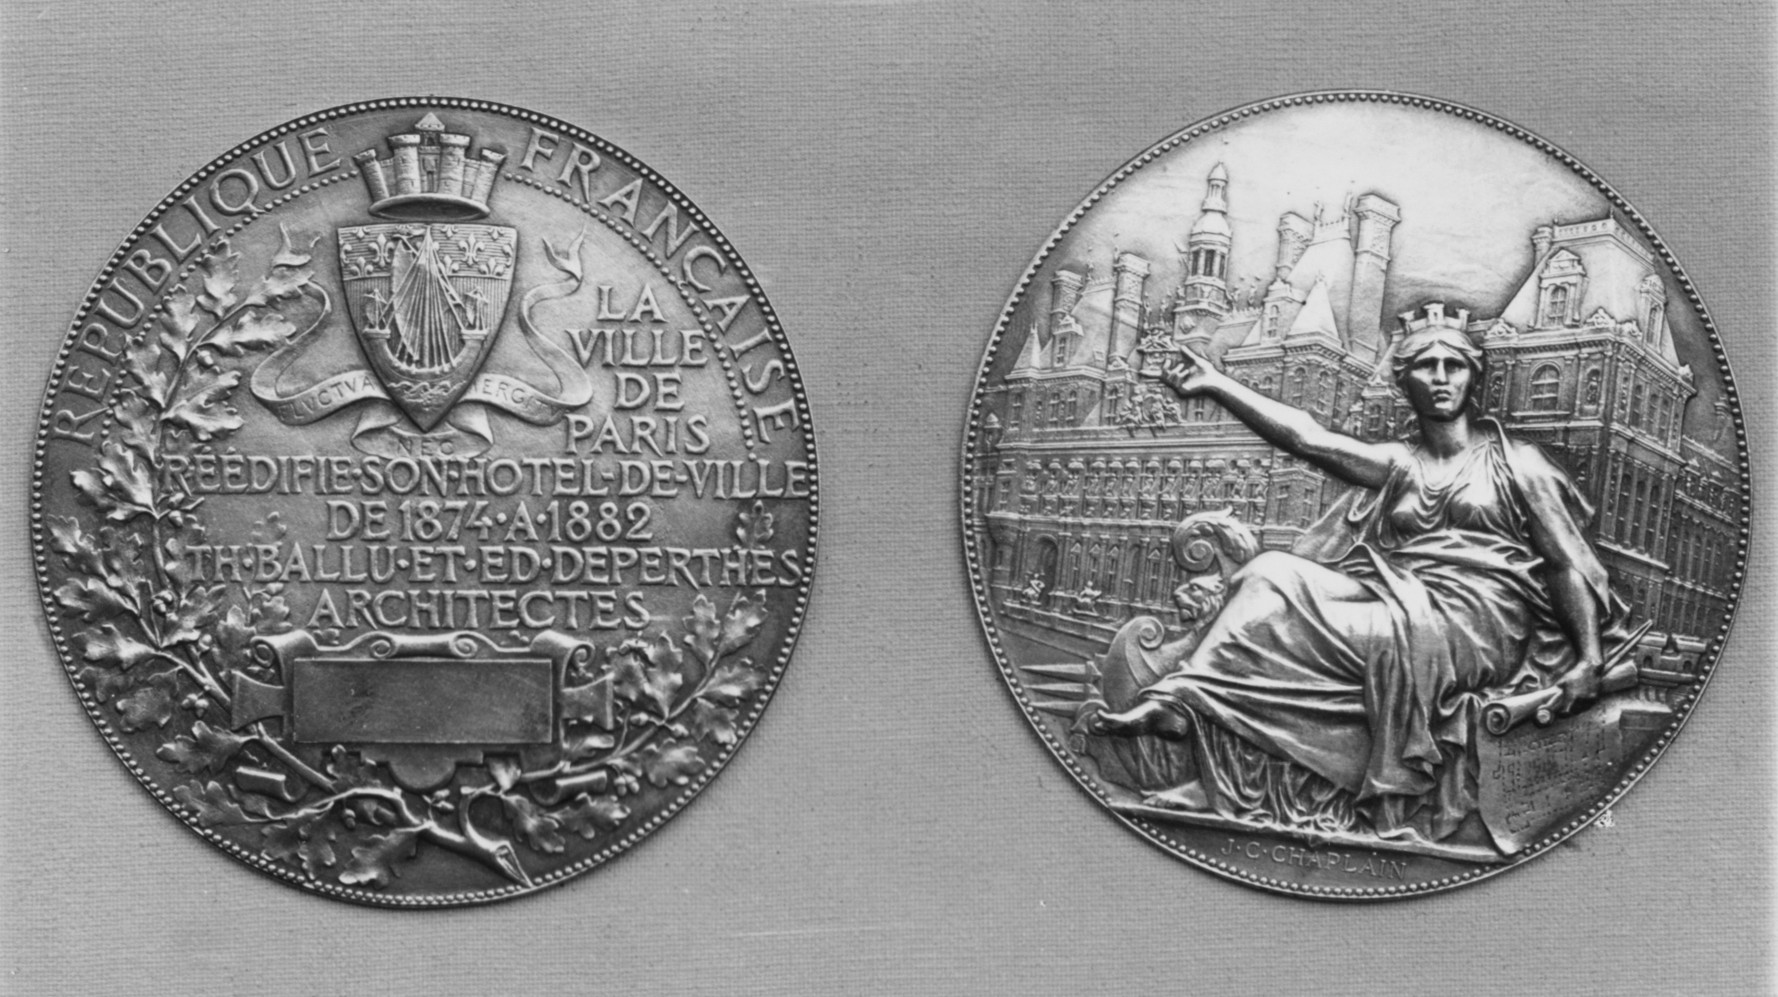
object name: medal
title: To commemorate the rebuilding of the Paris Hotel de Ville, burnt by the Communards in 1871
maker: jules-clément chaplain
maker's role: artist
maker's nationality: french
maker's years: 1839-1909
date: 1882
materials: bronze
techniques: silvered, struck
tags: buildings,women,coat of arms